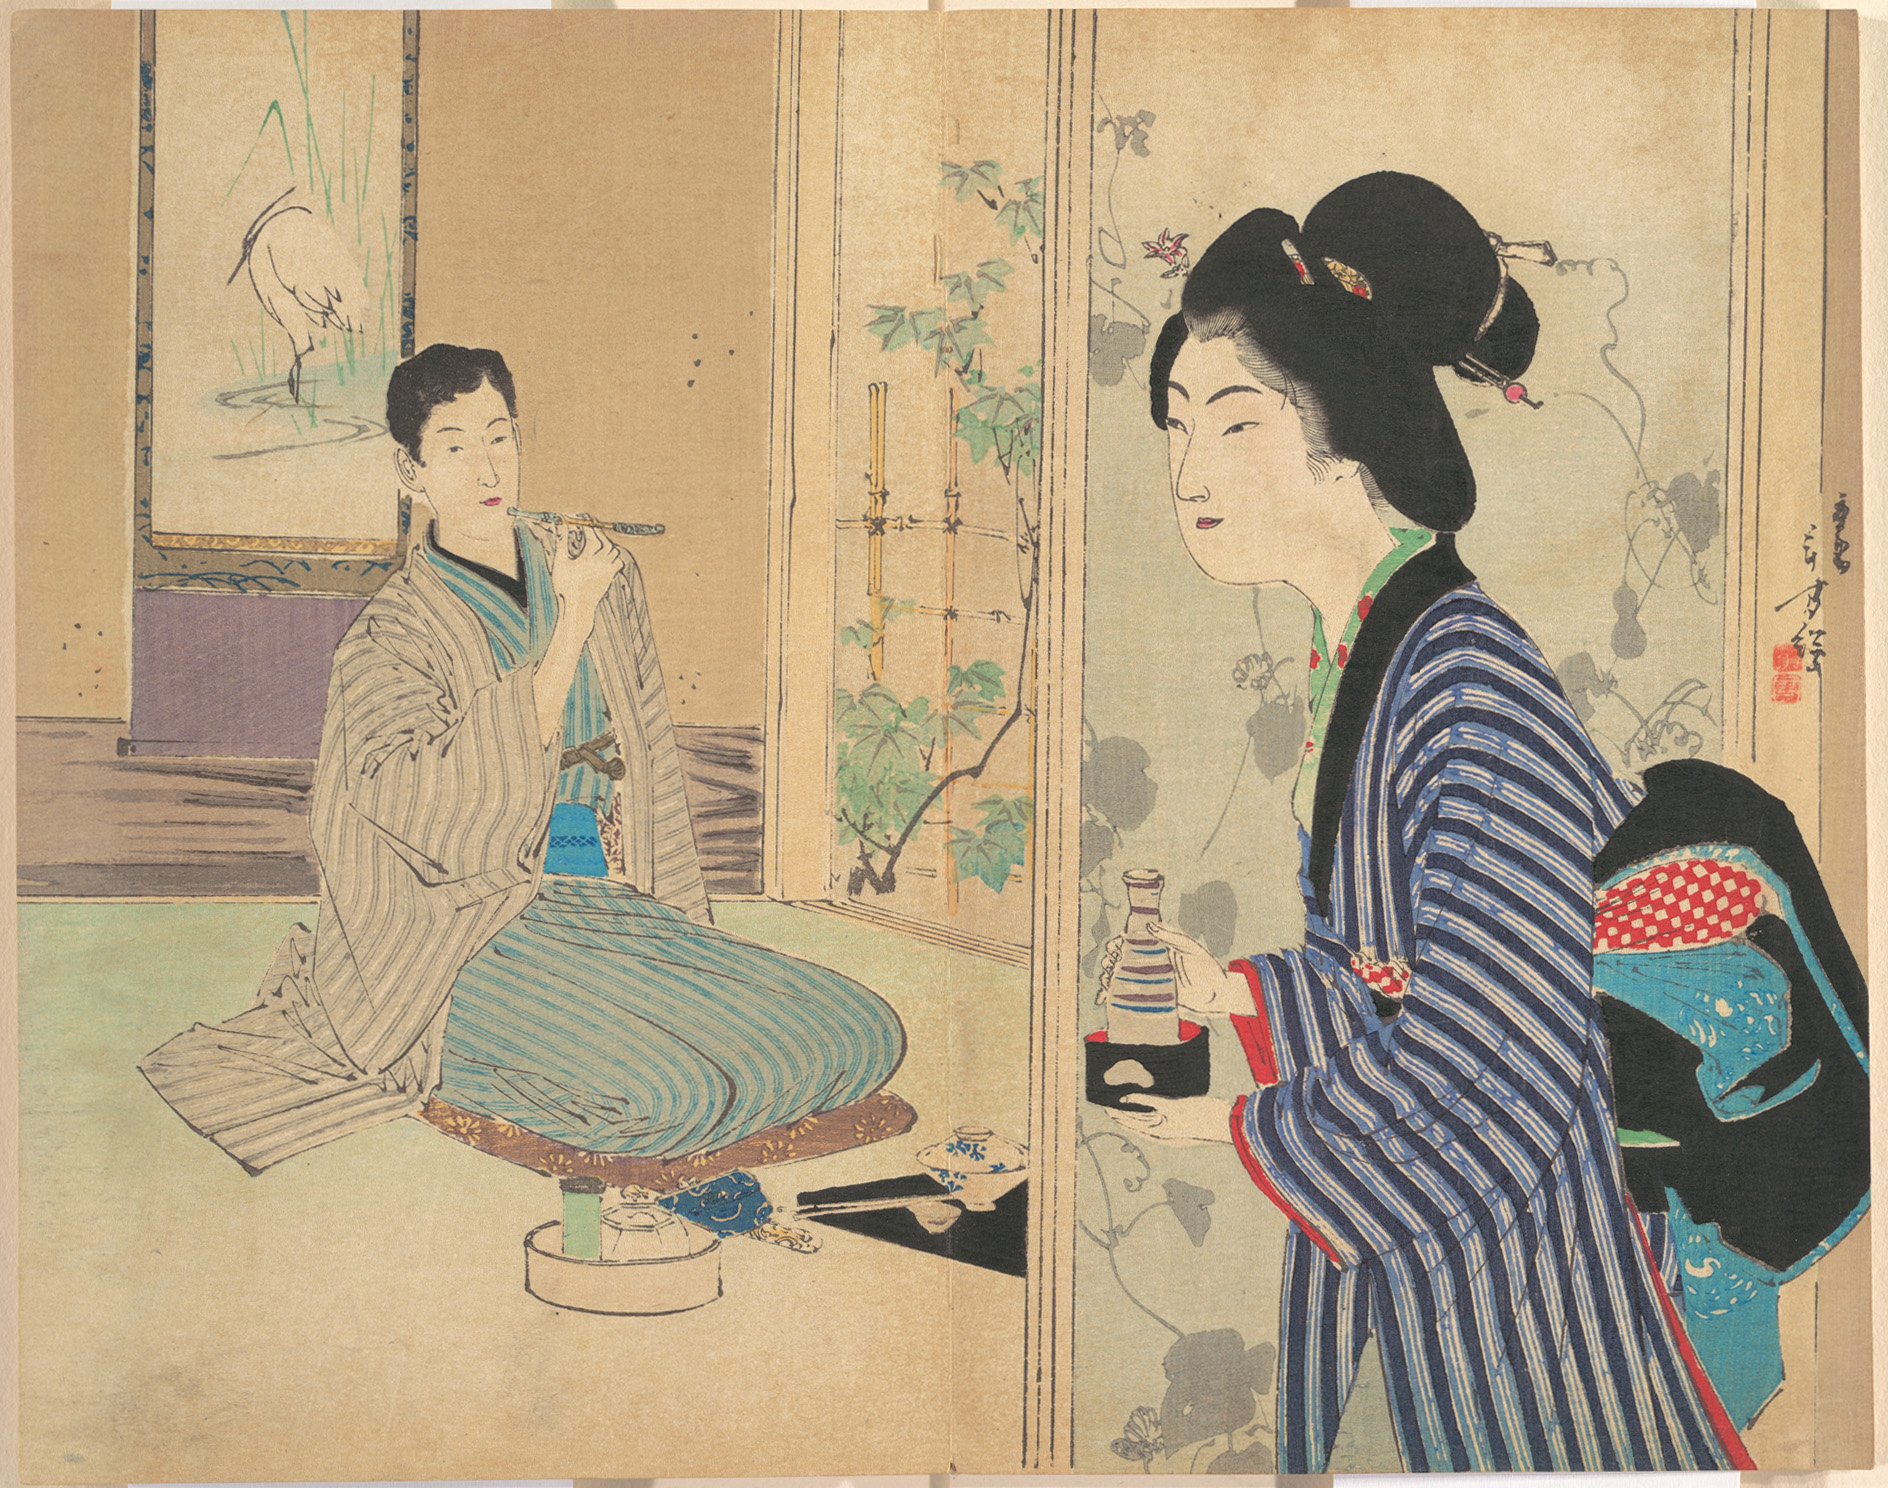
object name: print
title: The Eel Master (Unagi danna), illustration from Bugei Kurabu (Literary Club)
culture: japanese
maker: mizuno toshikata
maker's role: artist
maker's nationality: japanese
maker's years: 1866-1908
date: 1866-1908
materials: ink, paper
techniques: woodblock print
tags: men,women,smoking